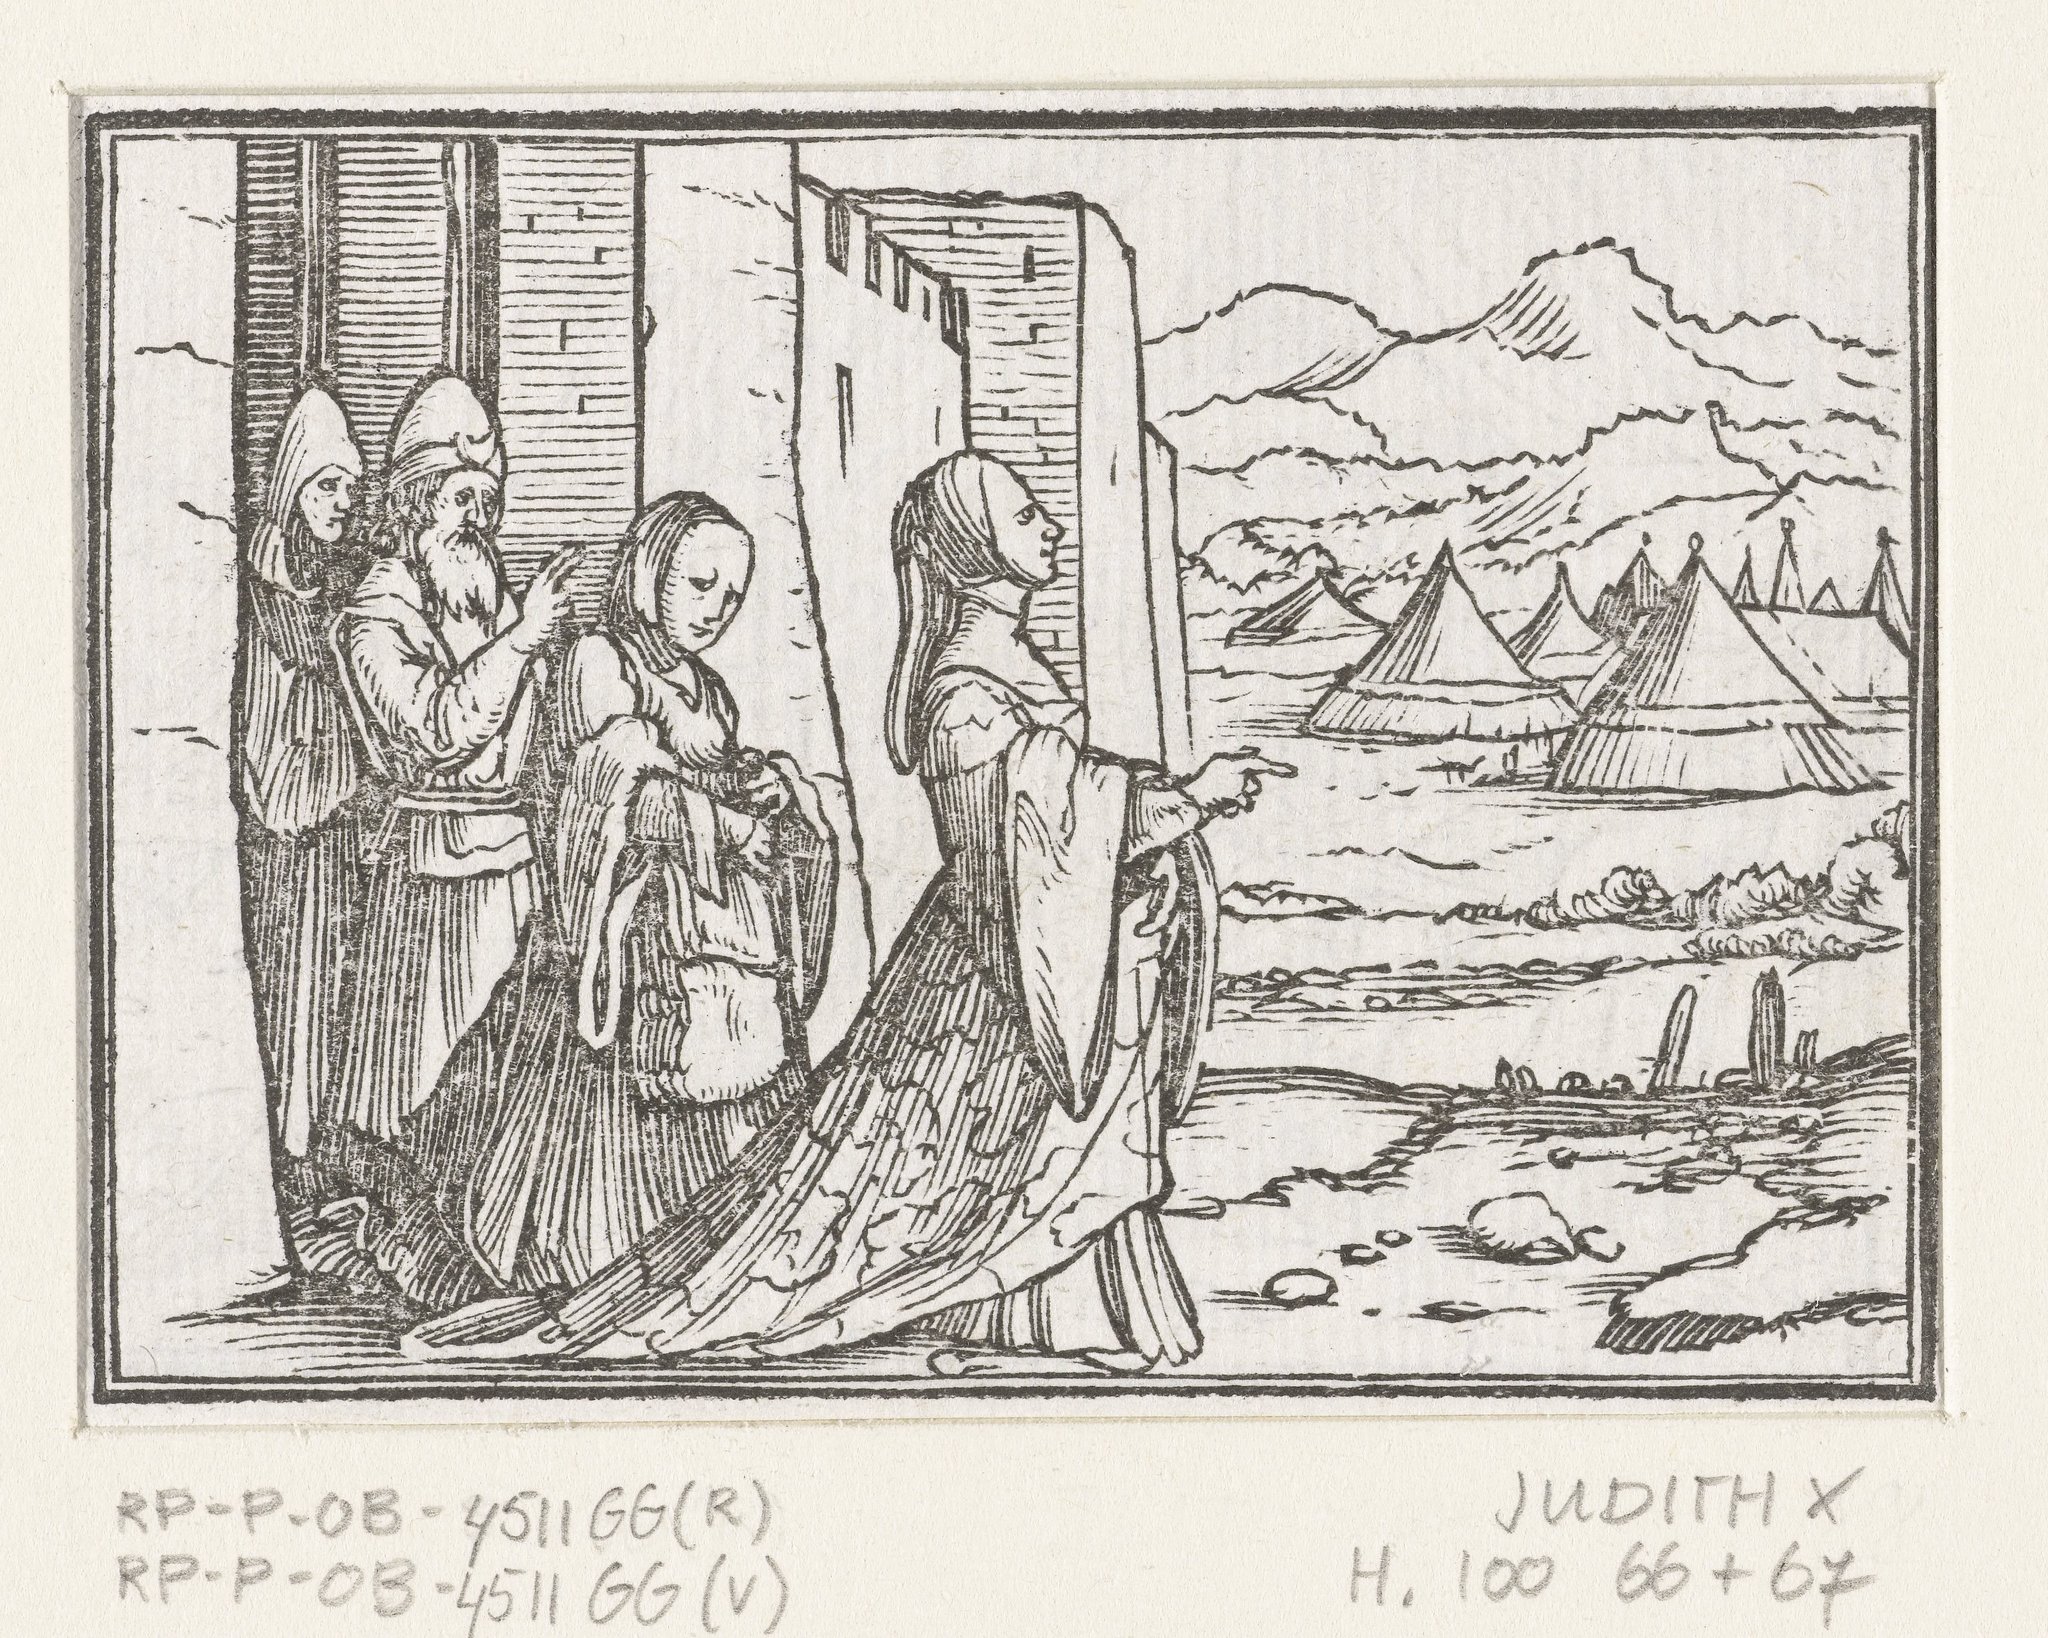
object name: book illustration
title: Judit en haar dienstmaagd gaan op weg naar Holofernes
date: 1538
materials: paper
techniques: woodcut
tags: judith and her maidservant take leave of the elders at the city gate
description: Judit loopt in haar mooiste kleding en begeleid door haar dienstmaagd door de stadspoort de stad Betulia uit. De stadsoudsten staan bij de stadspoort en een van hen maakt een zegenend gebaar. Rechts in de verte ligt het tentenkamp van Holofernes. In de marge boven de afbeelding staat de tekst Judith X.